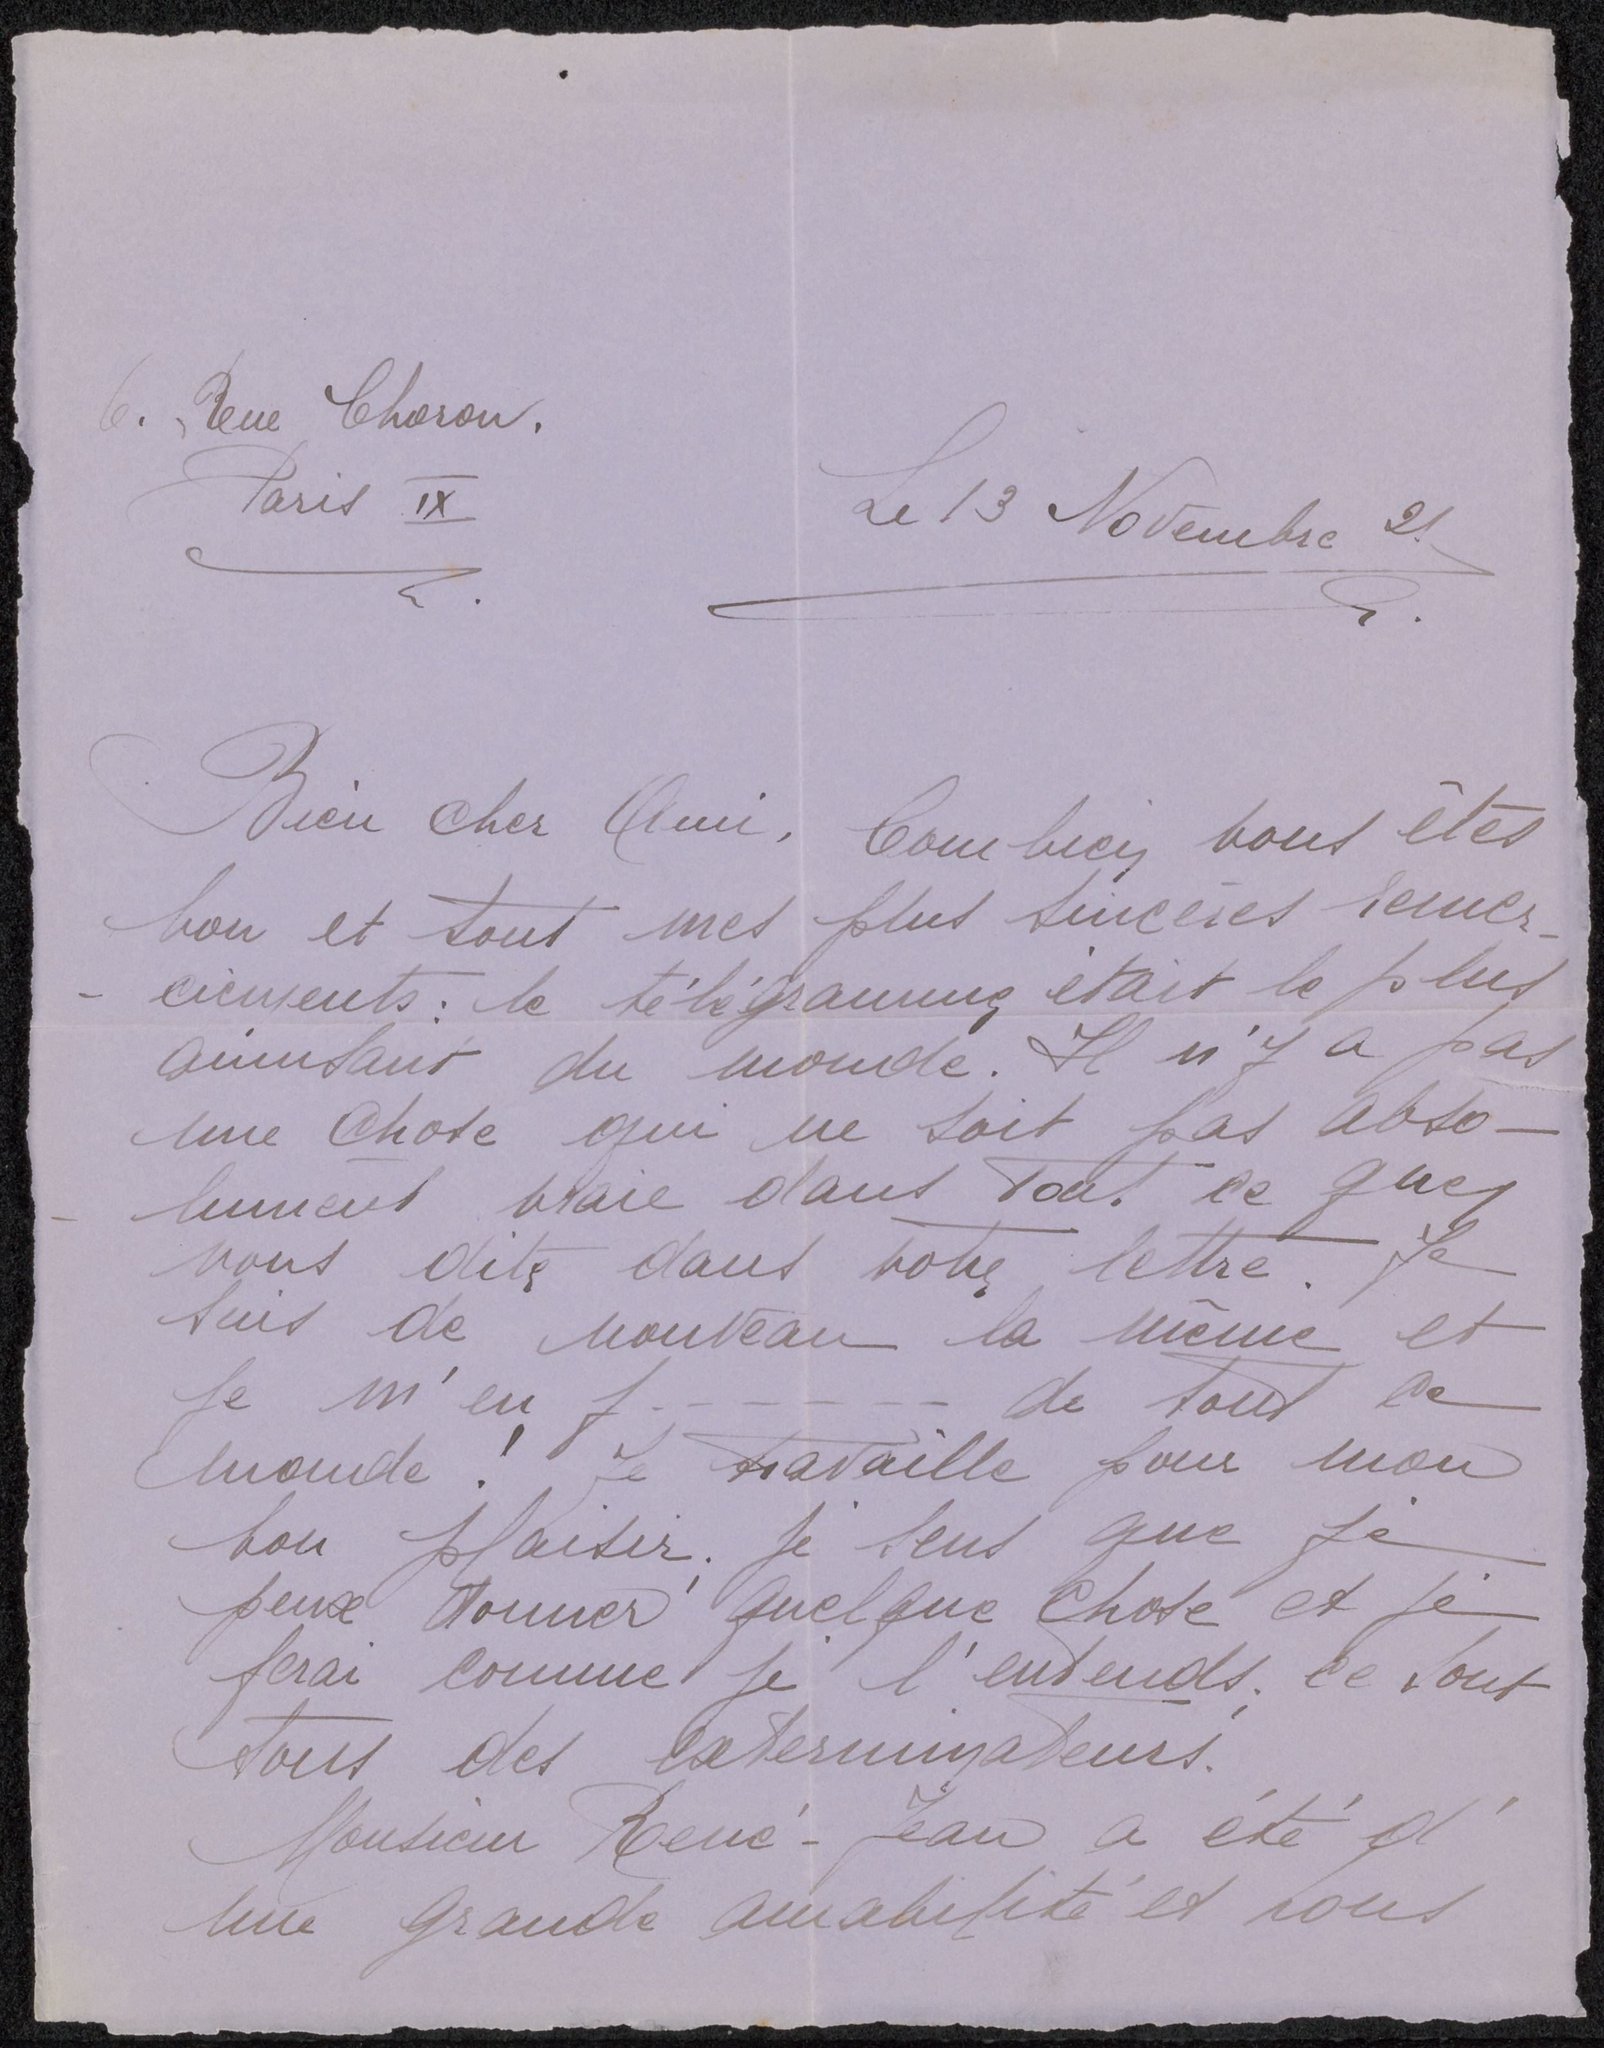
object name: letter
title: Brief aan Philip Zilcken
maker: rose imel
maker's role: draughtsman, painter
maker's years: 1901-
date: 1921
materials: ink, paper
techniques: pen, writing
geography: paris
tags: the hague, philip zilcken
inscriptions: collector's mark: ‘RPK’